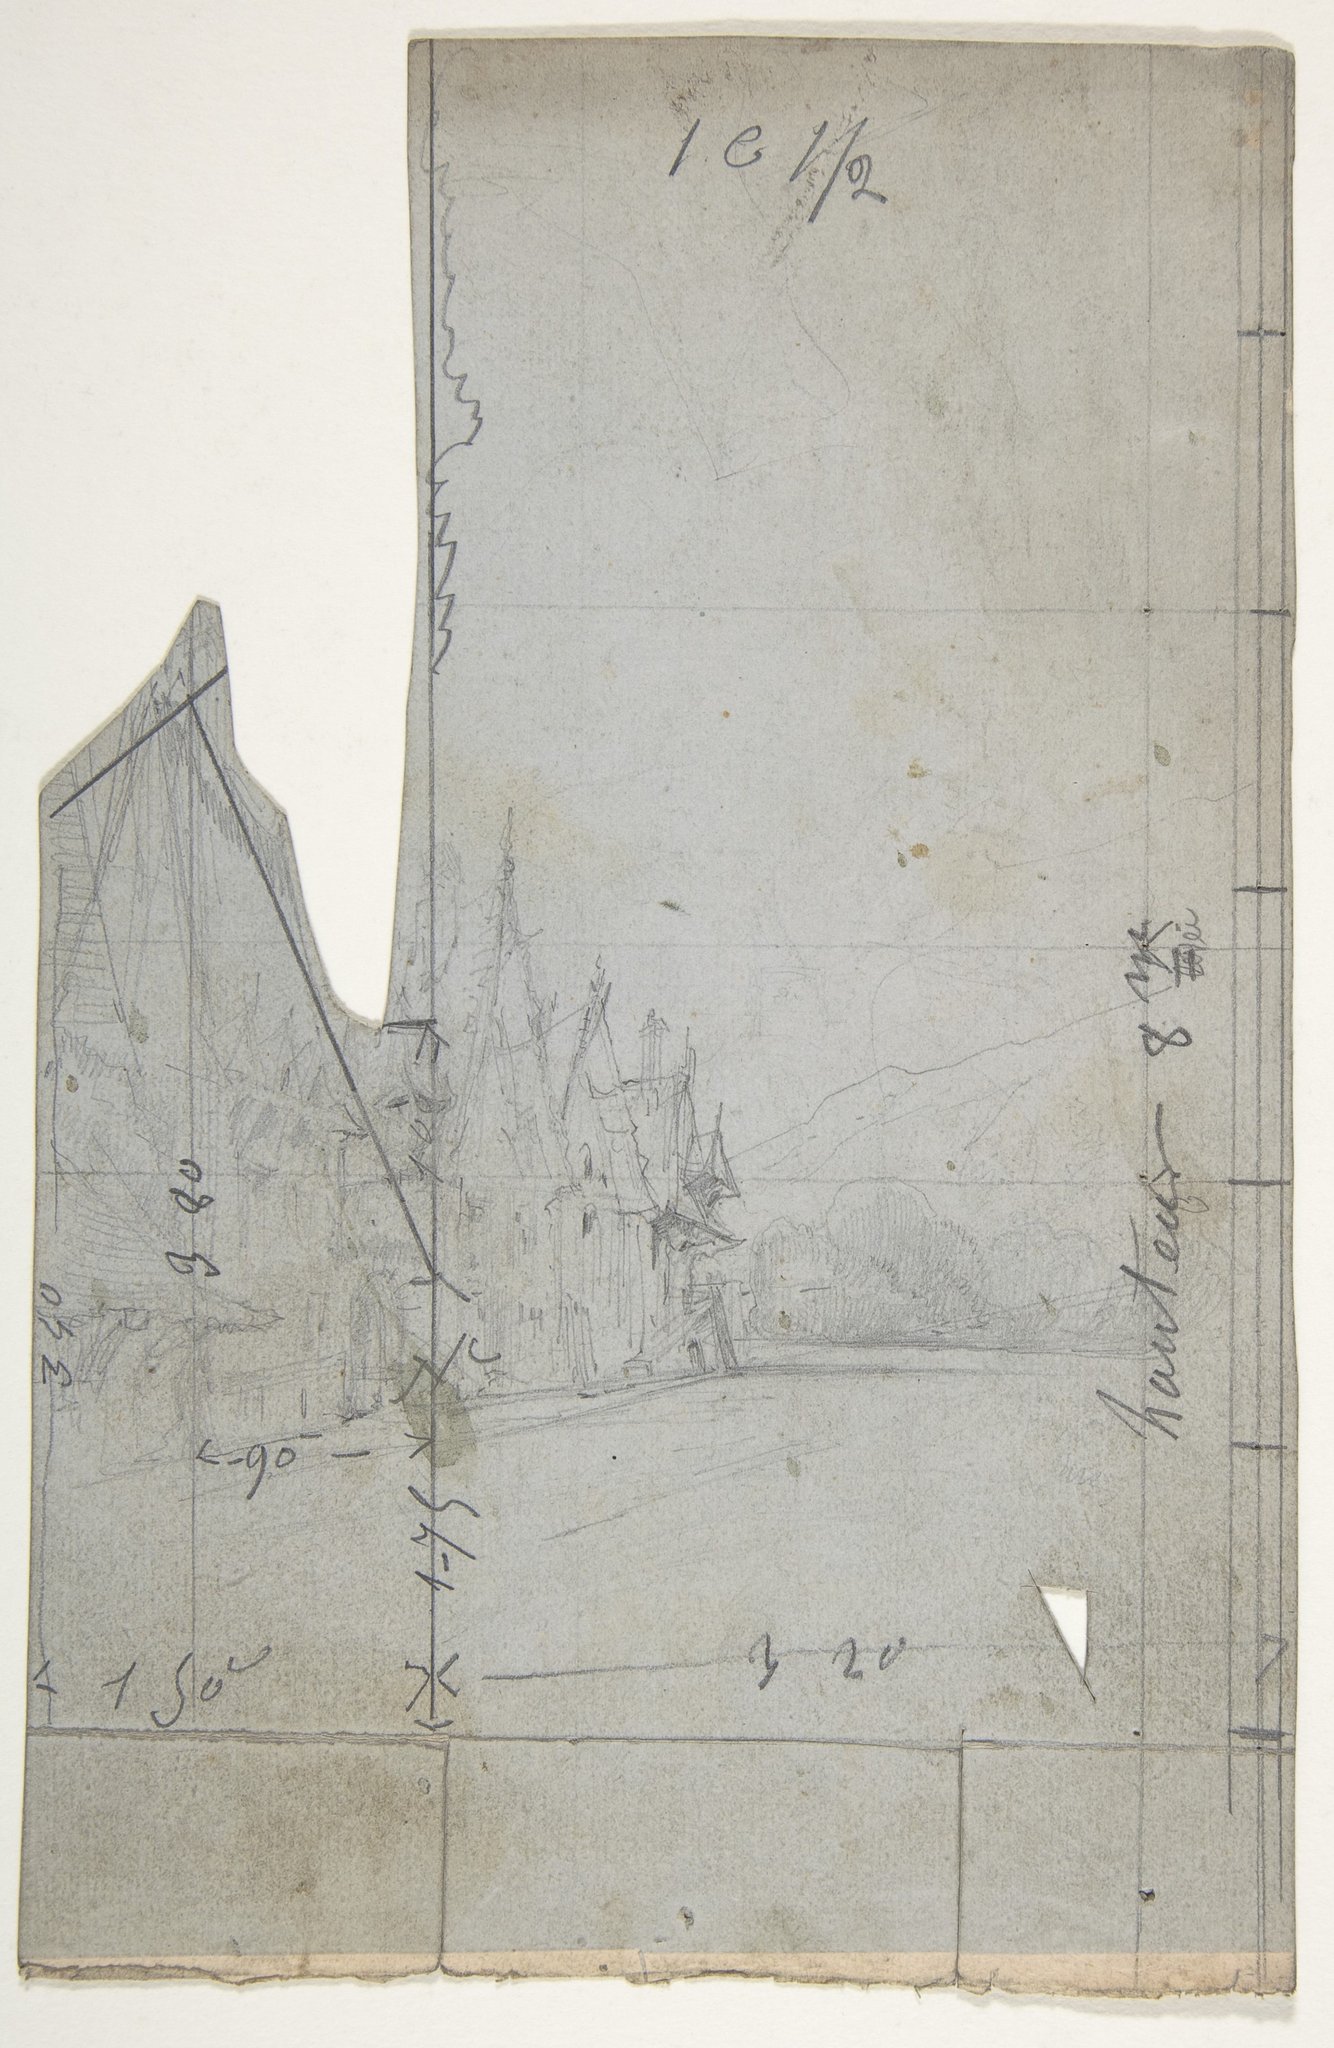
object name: drawing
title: Design for a Stage Set at the Opéra, Paris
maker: eugène cicéri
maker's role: artist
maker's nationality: french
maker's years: 1813-1890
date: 1830-1890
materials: graphite, paper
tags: stage design